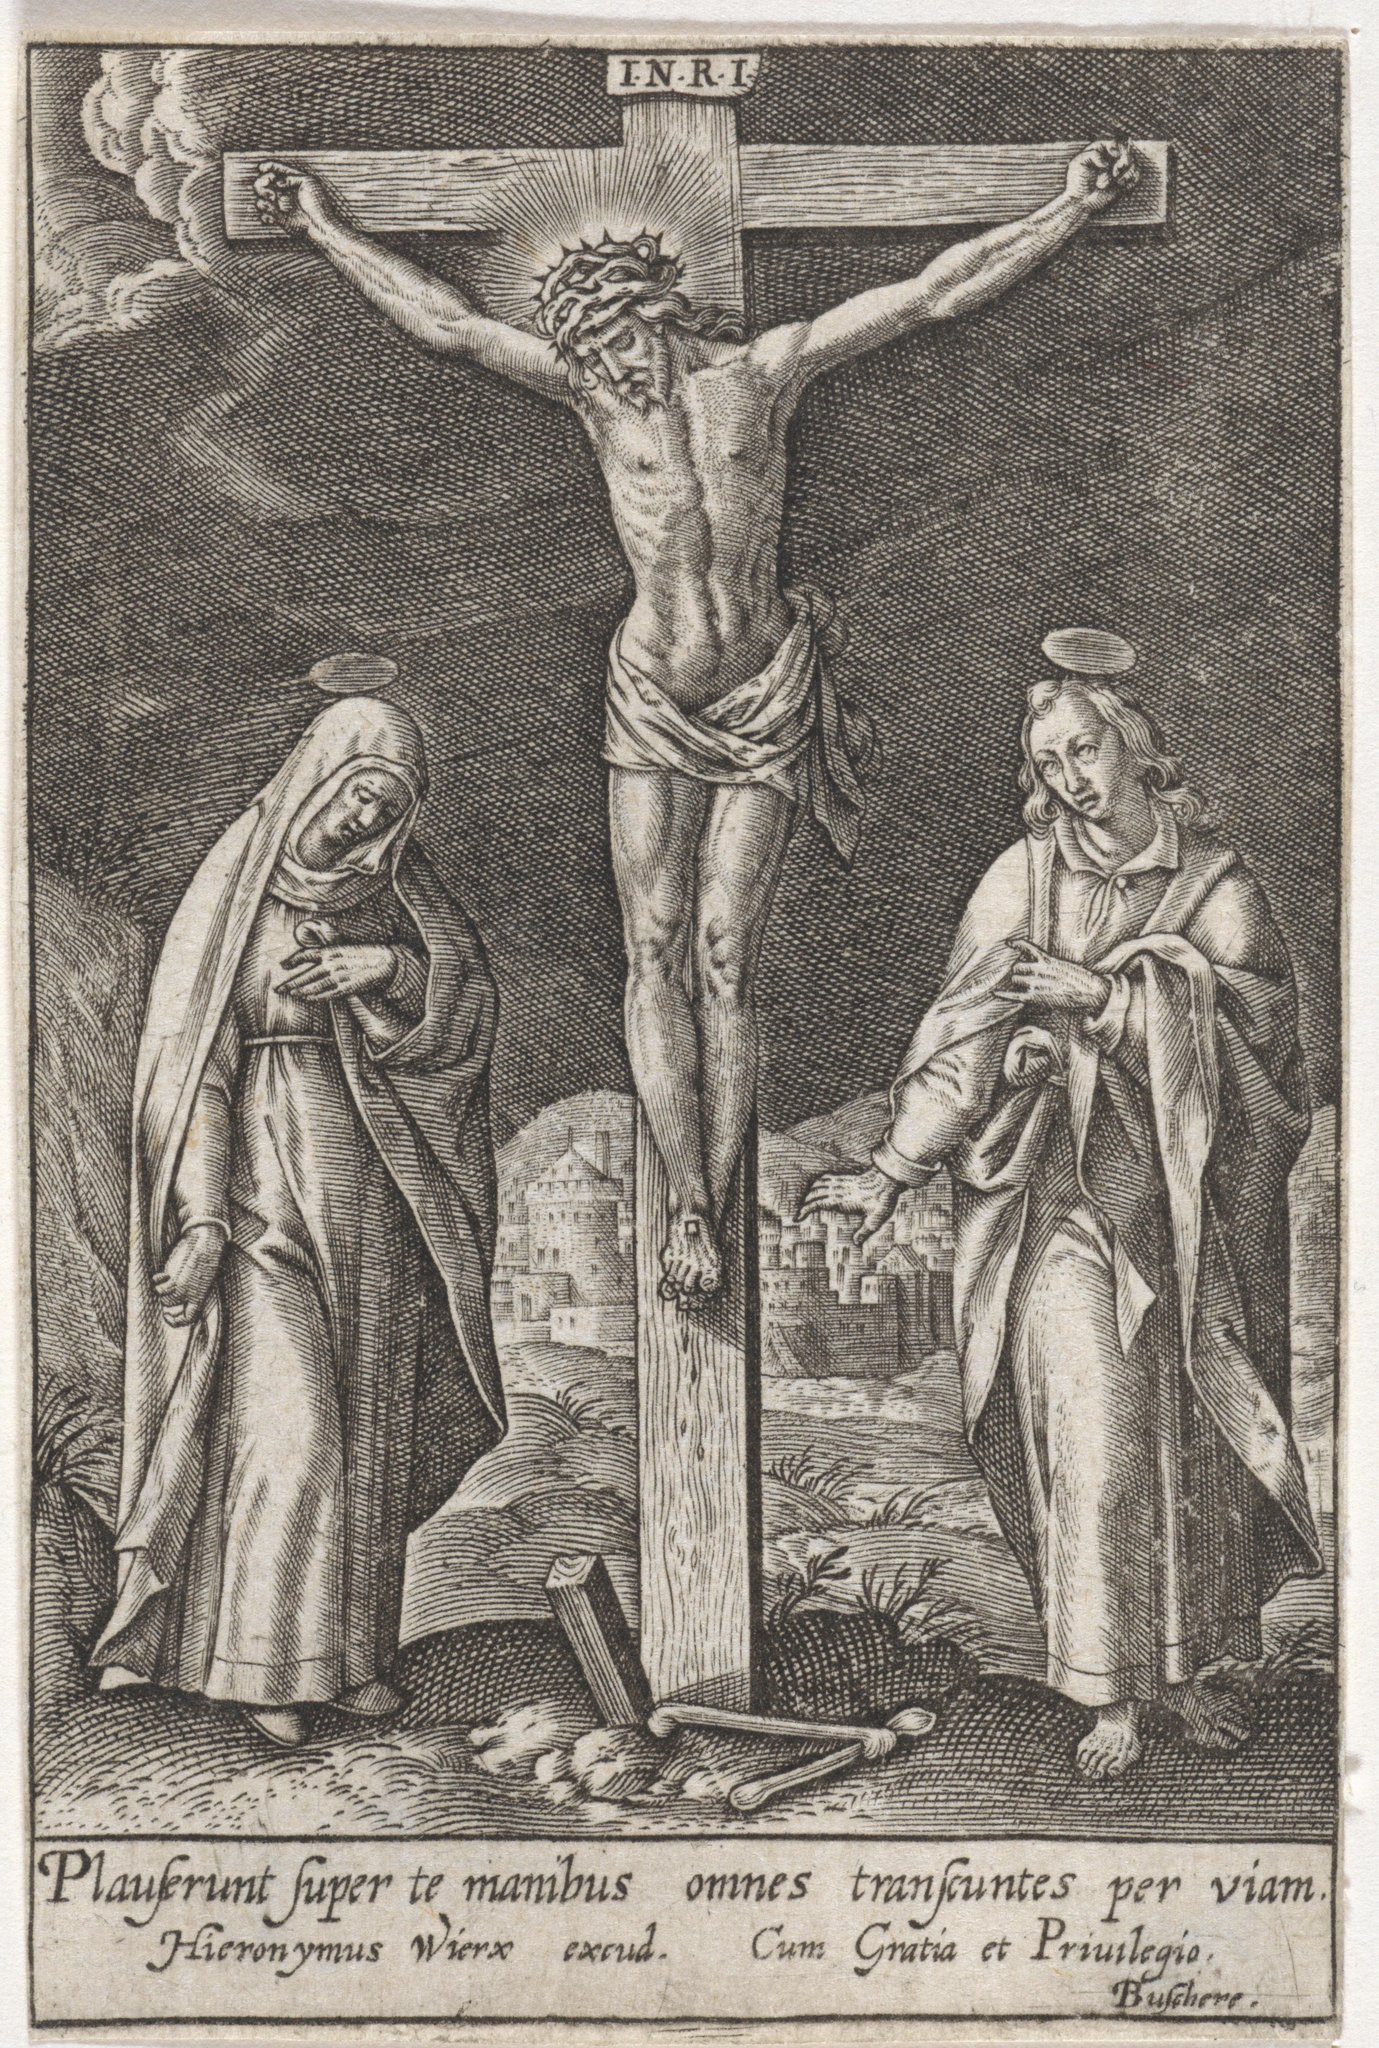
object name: print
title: Kruisiging van Christus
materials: paper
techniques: engraving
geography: antwerp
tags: crucified christ, with particular persons under the cross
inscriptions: collector's mark: Lugt 2228, collector's mark: Lugt 2542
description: Christus hangt aan het kruis. Aan de voet van het kruis Maria en Johannes. In de marge een onderschrift in het Latijn.